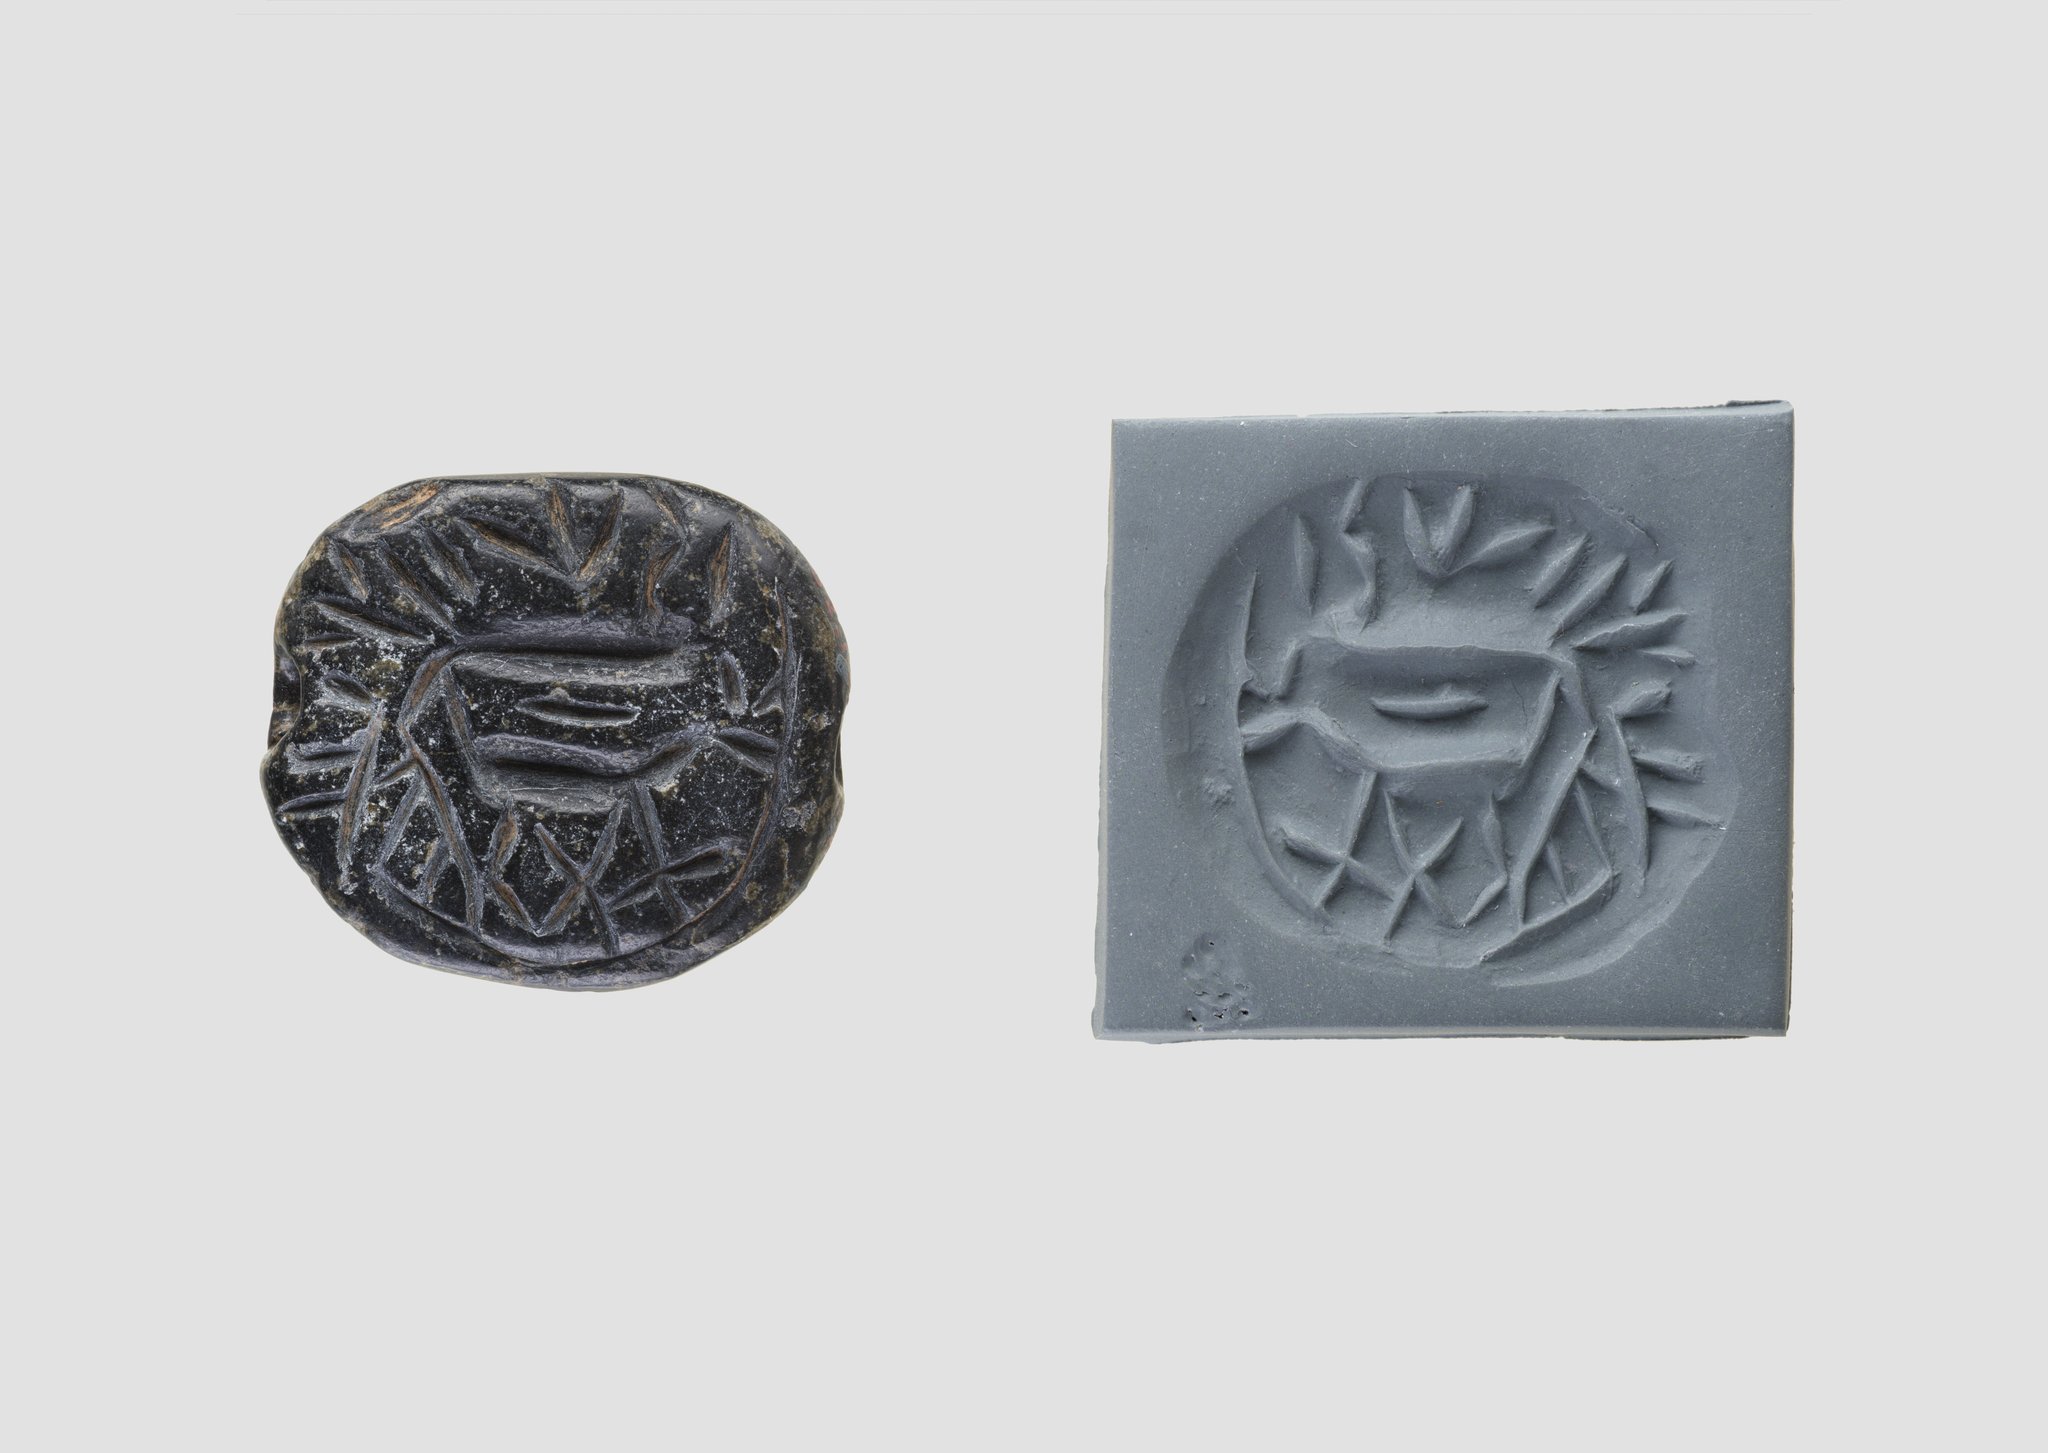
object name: stamp seal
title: Low hemispheroid seal with later inscription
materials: stone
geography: western iran (?)